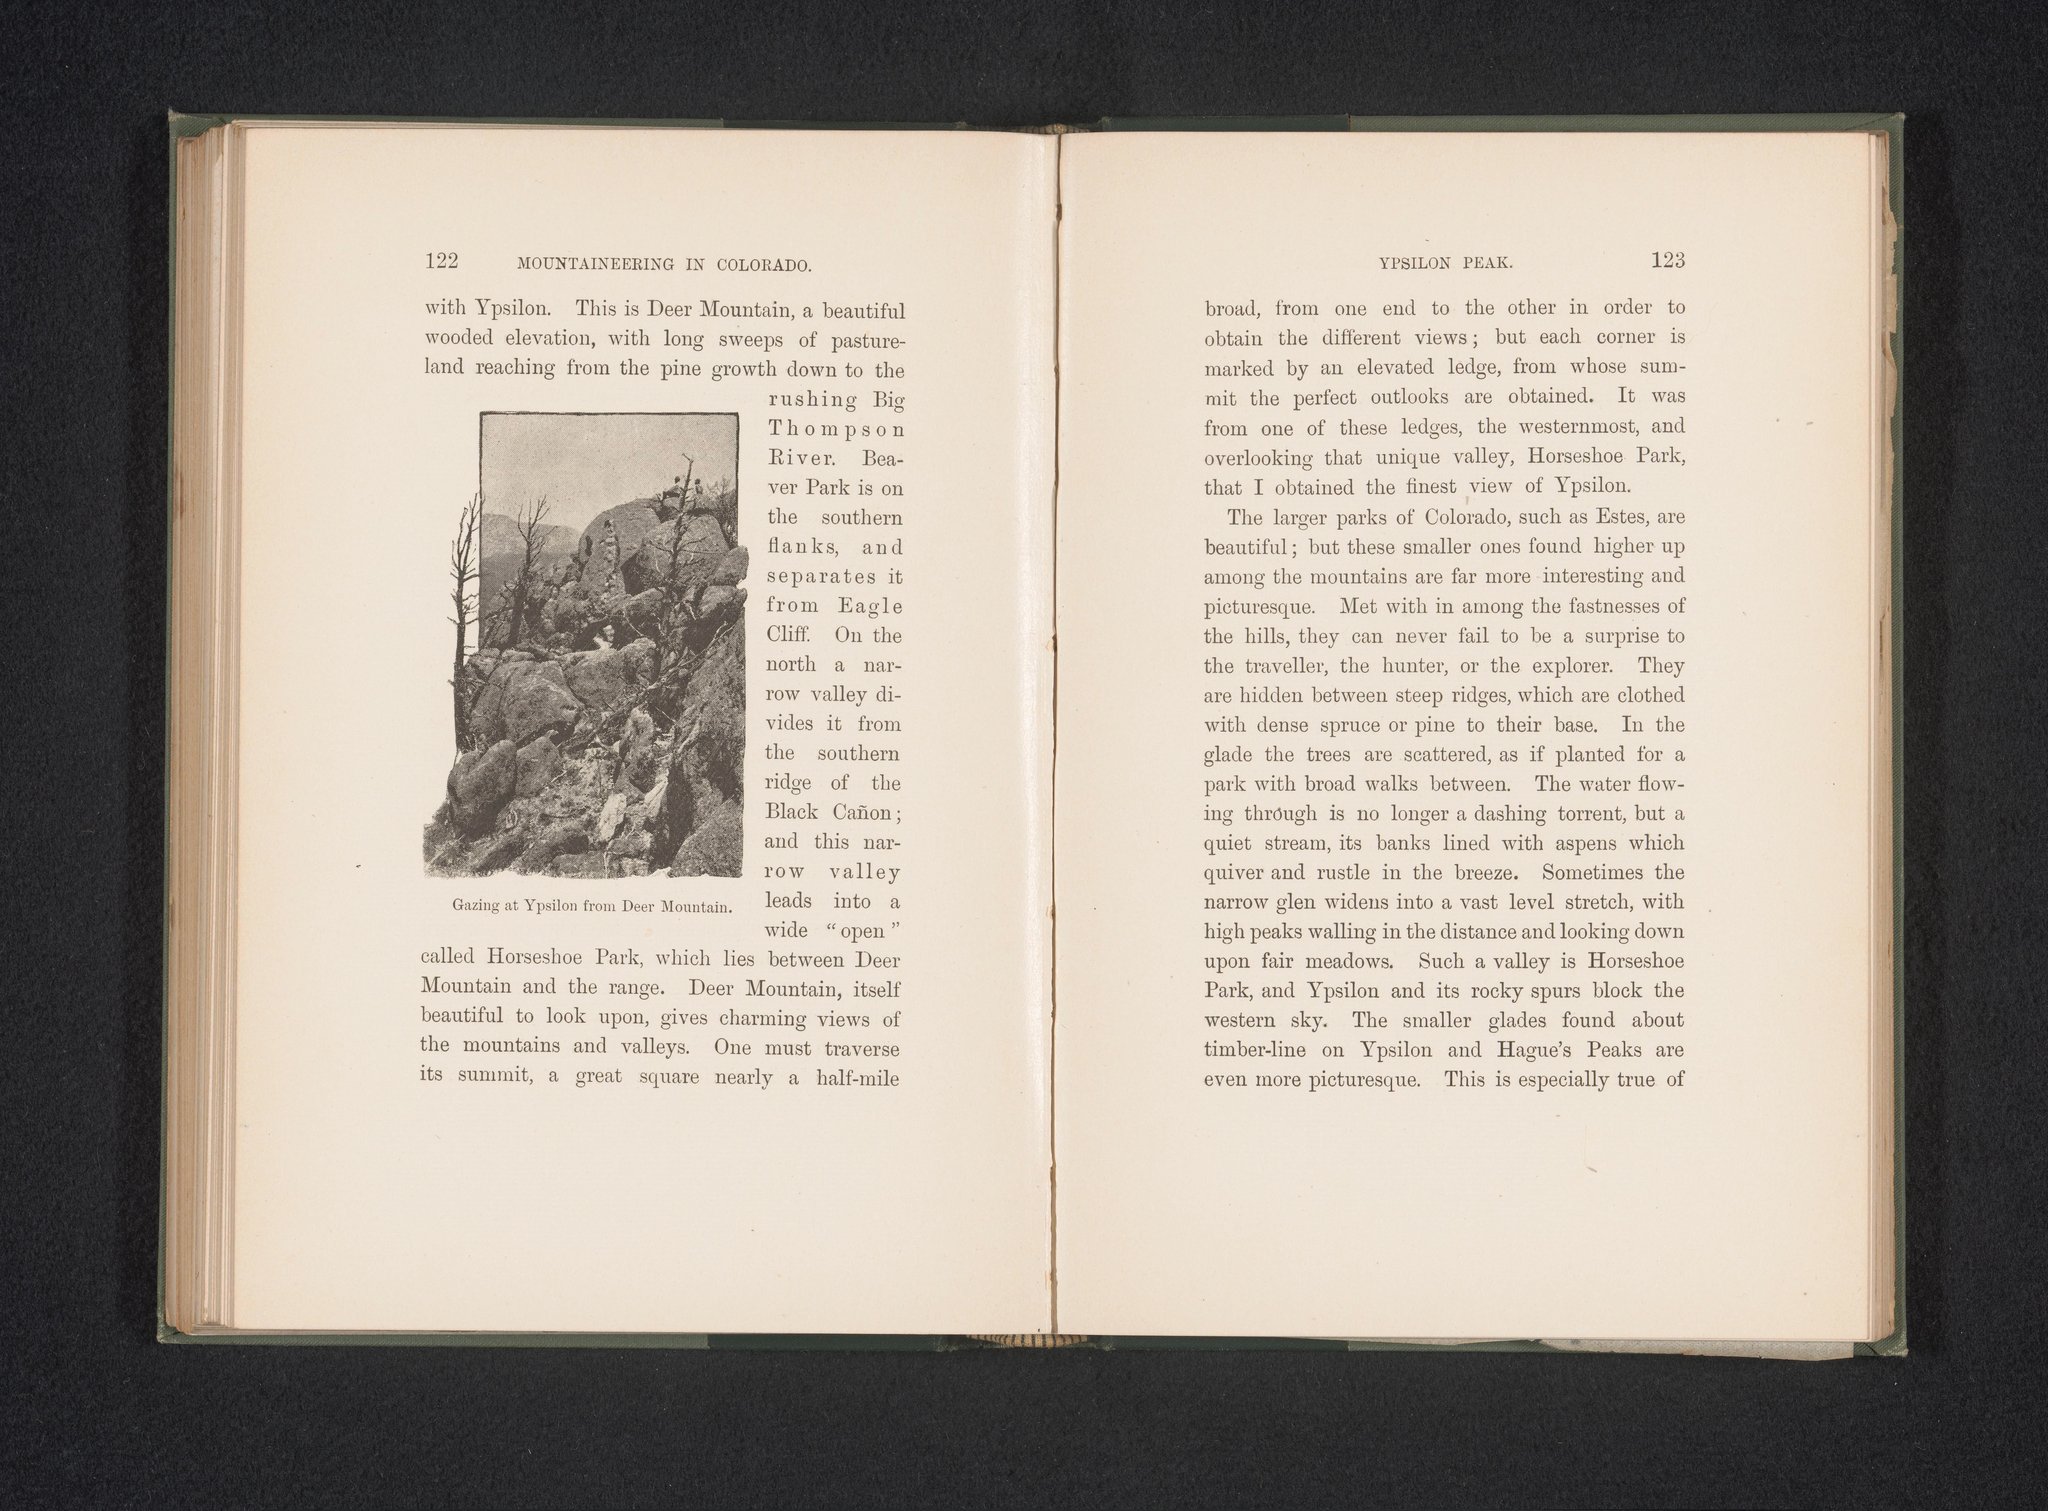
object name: page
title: Gazing at Ypsilon from Deer Mountain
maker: frederick hastings chapin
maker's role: antropoloog, archeoloog, fotograaf, schrijver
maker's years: 1852-1900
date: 1885-1890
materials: paper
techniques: autotype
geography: boston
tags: mountain climbing, mountaineering, mountains